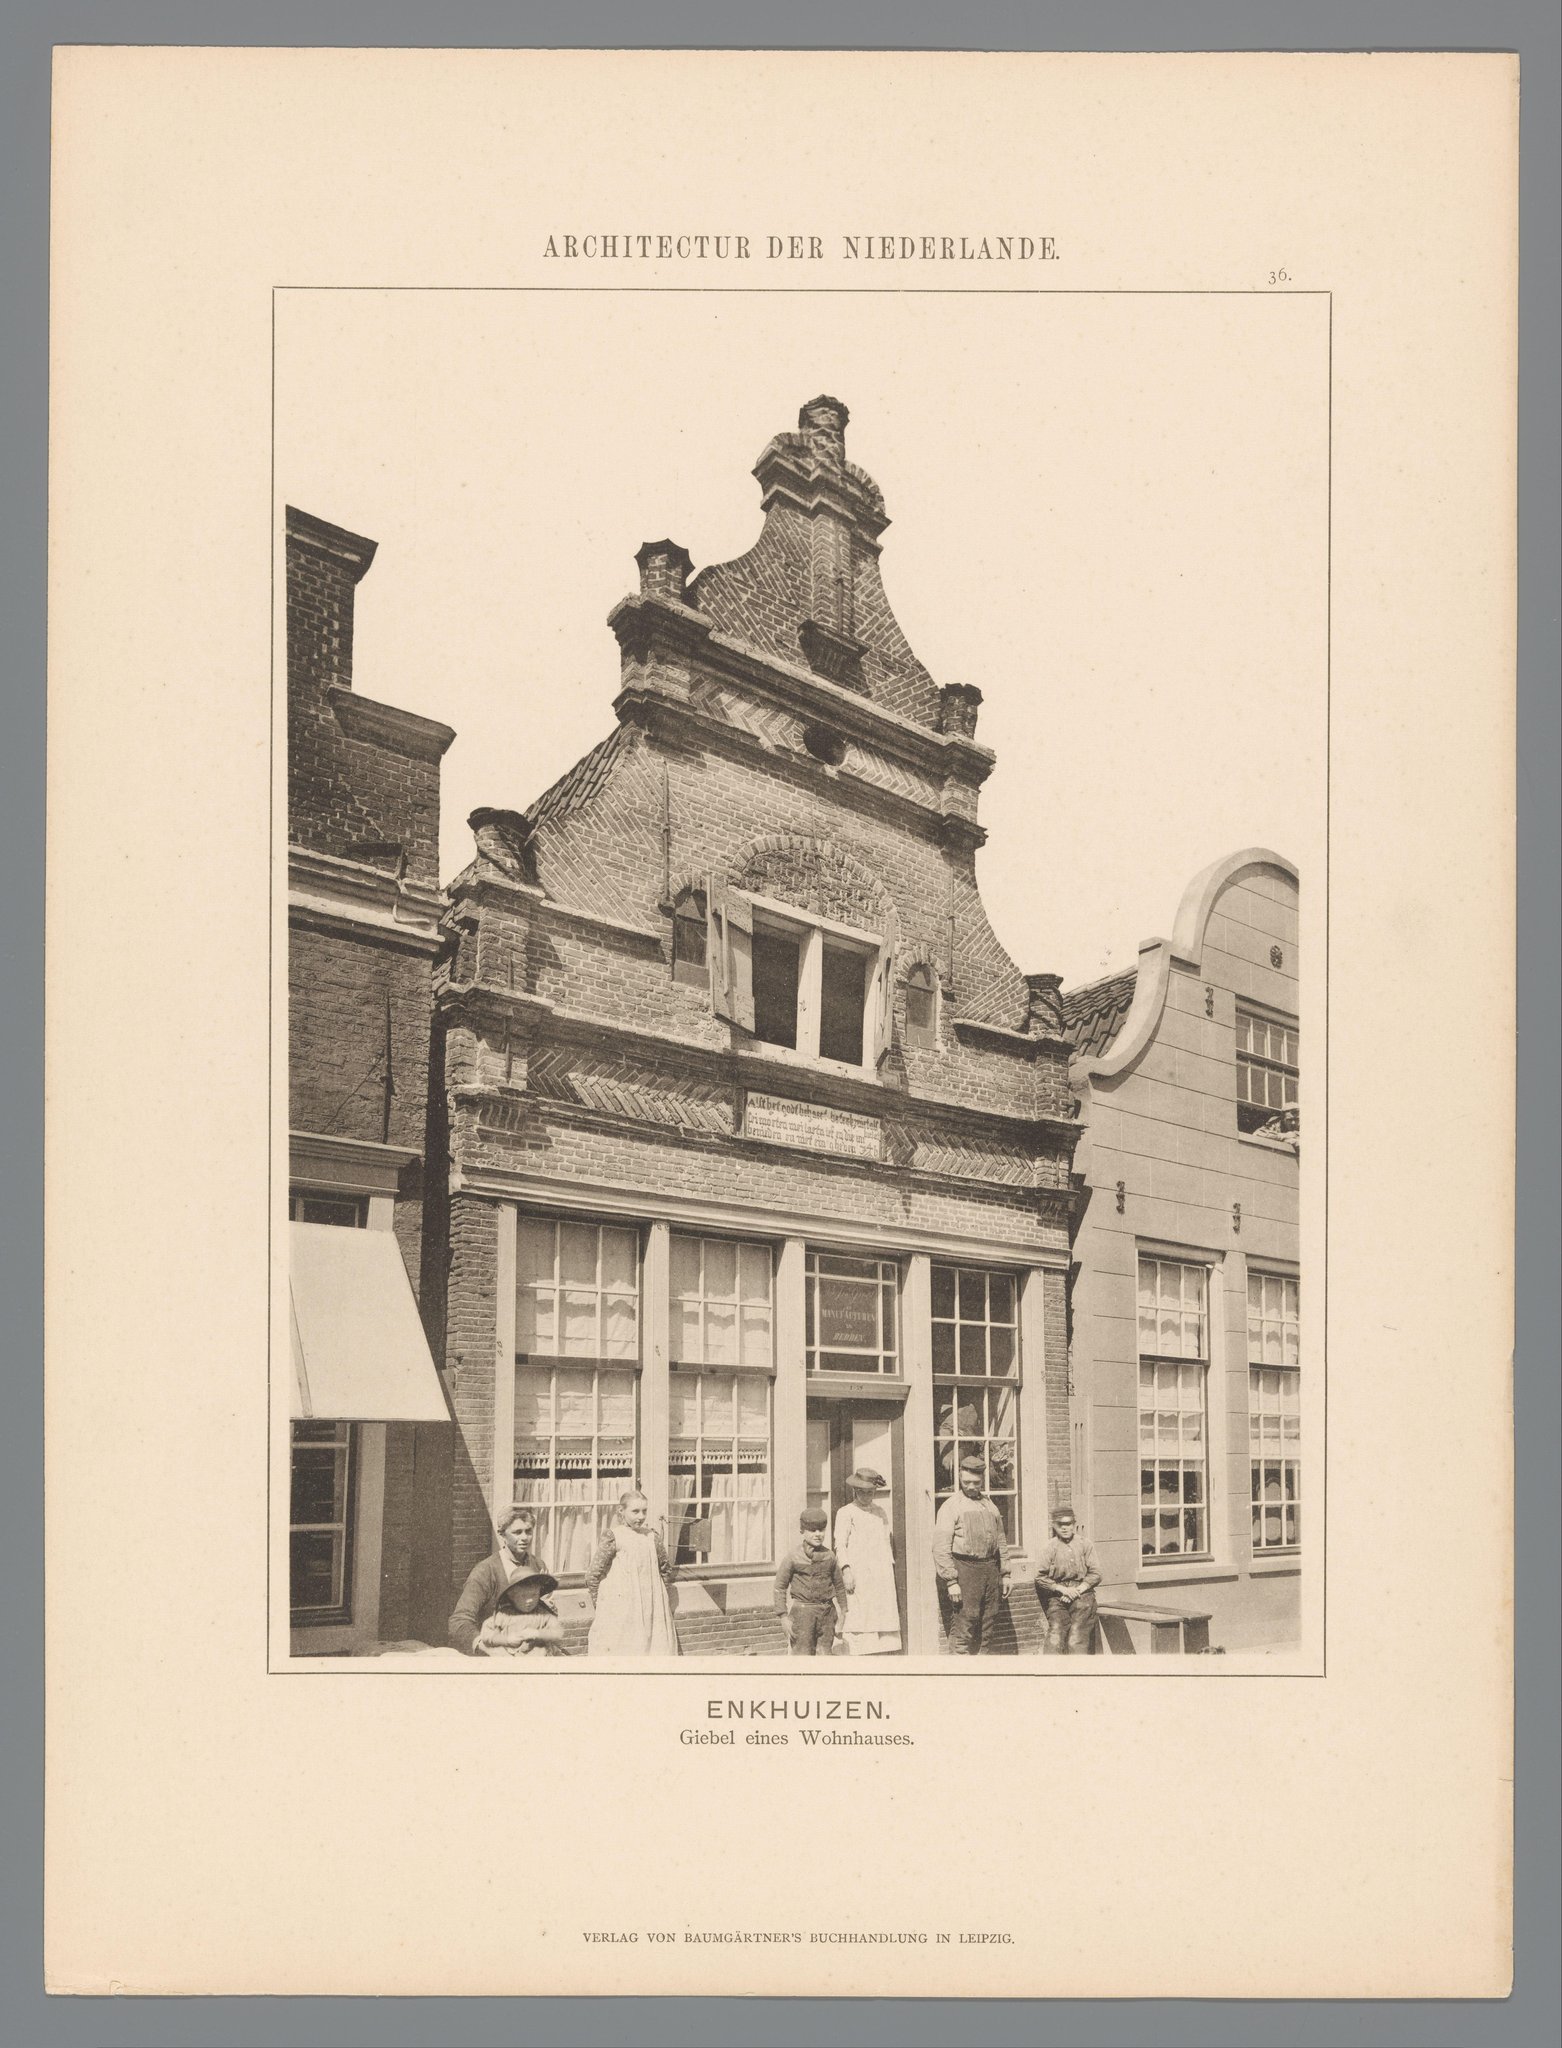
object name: photomechanical print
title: Gezicht op een huis in Enkhuizen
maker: Anonymous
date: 1894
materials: paper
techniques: photograph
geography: leipzig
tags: urban housing, façade (of house or building), enkhuizen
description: Afdruk uit: Krook, L. Architectur der Niederlande. Leipzig: Baumgärtner's Buchhandlung, 1894.